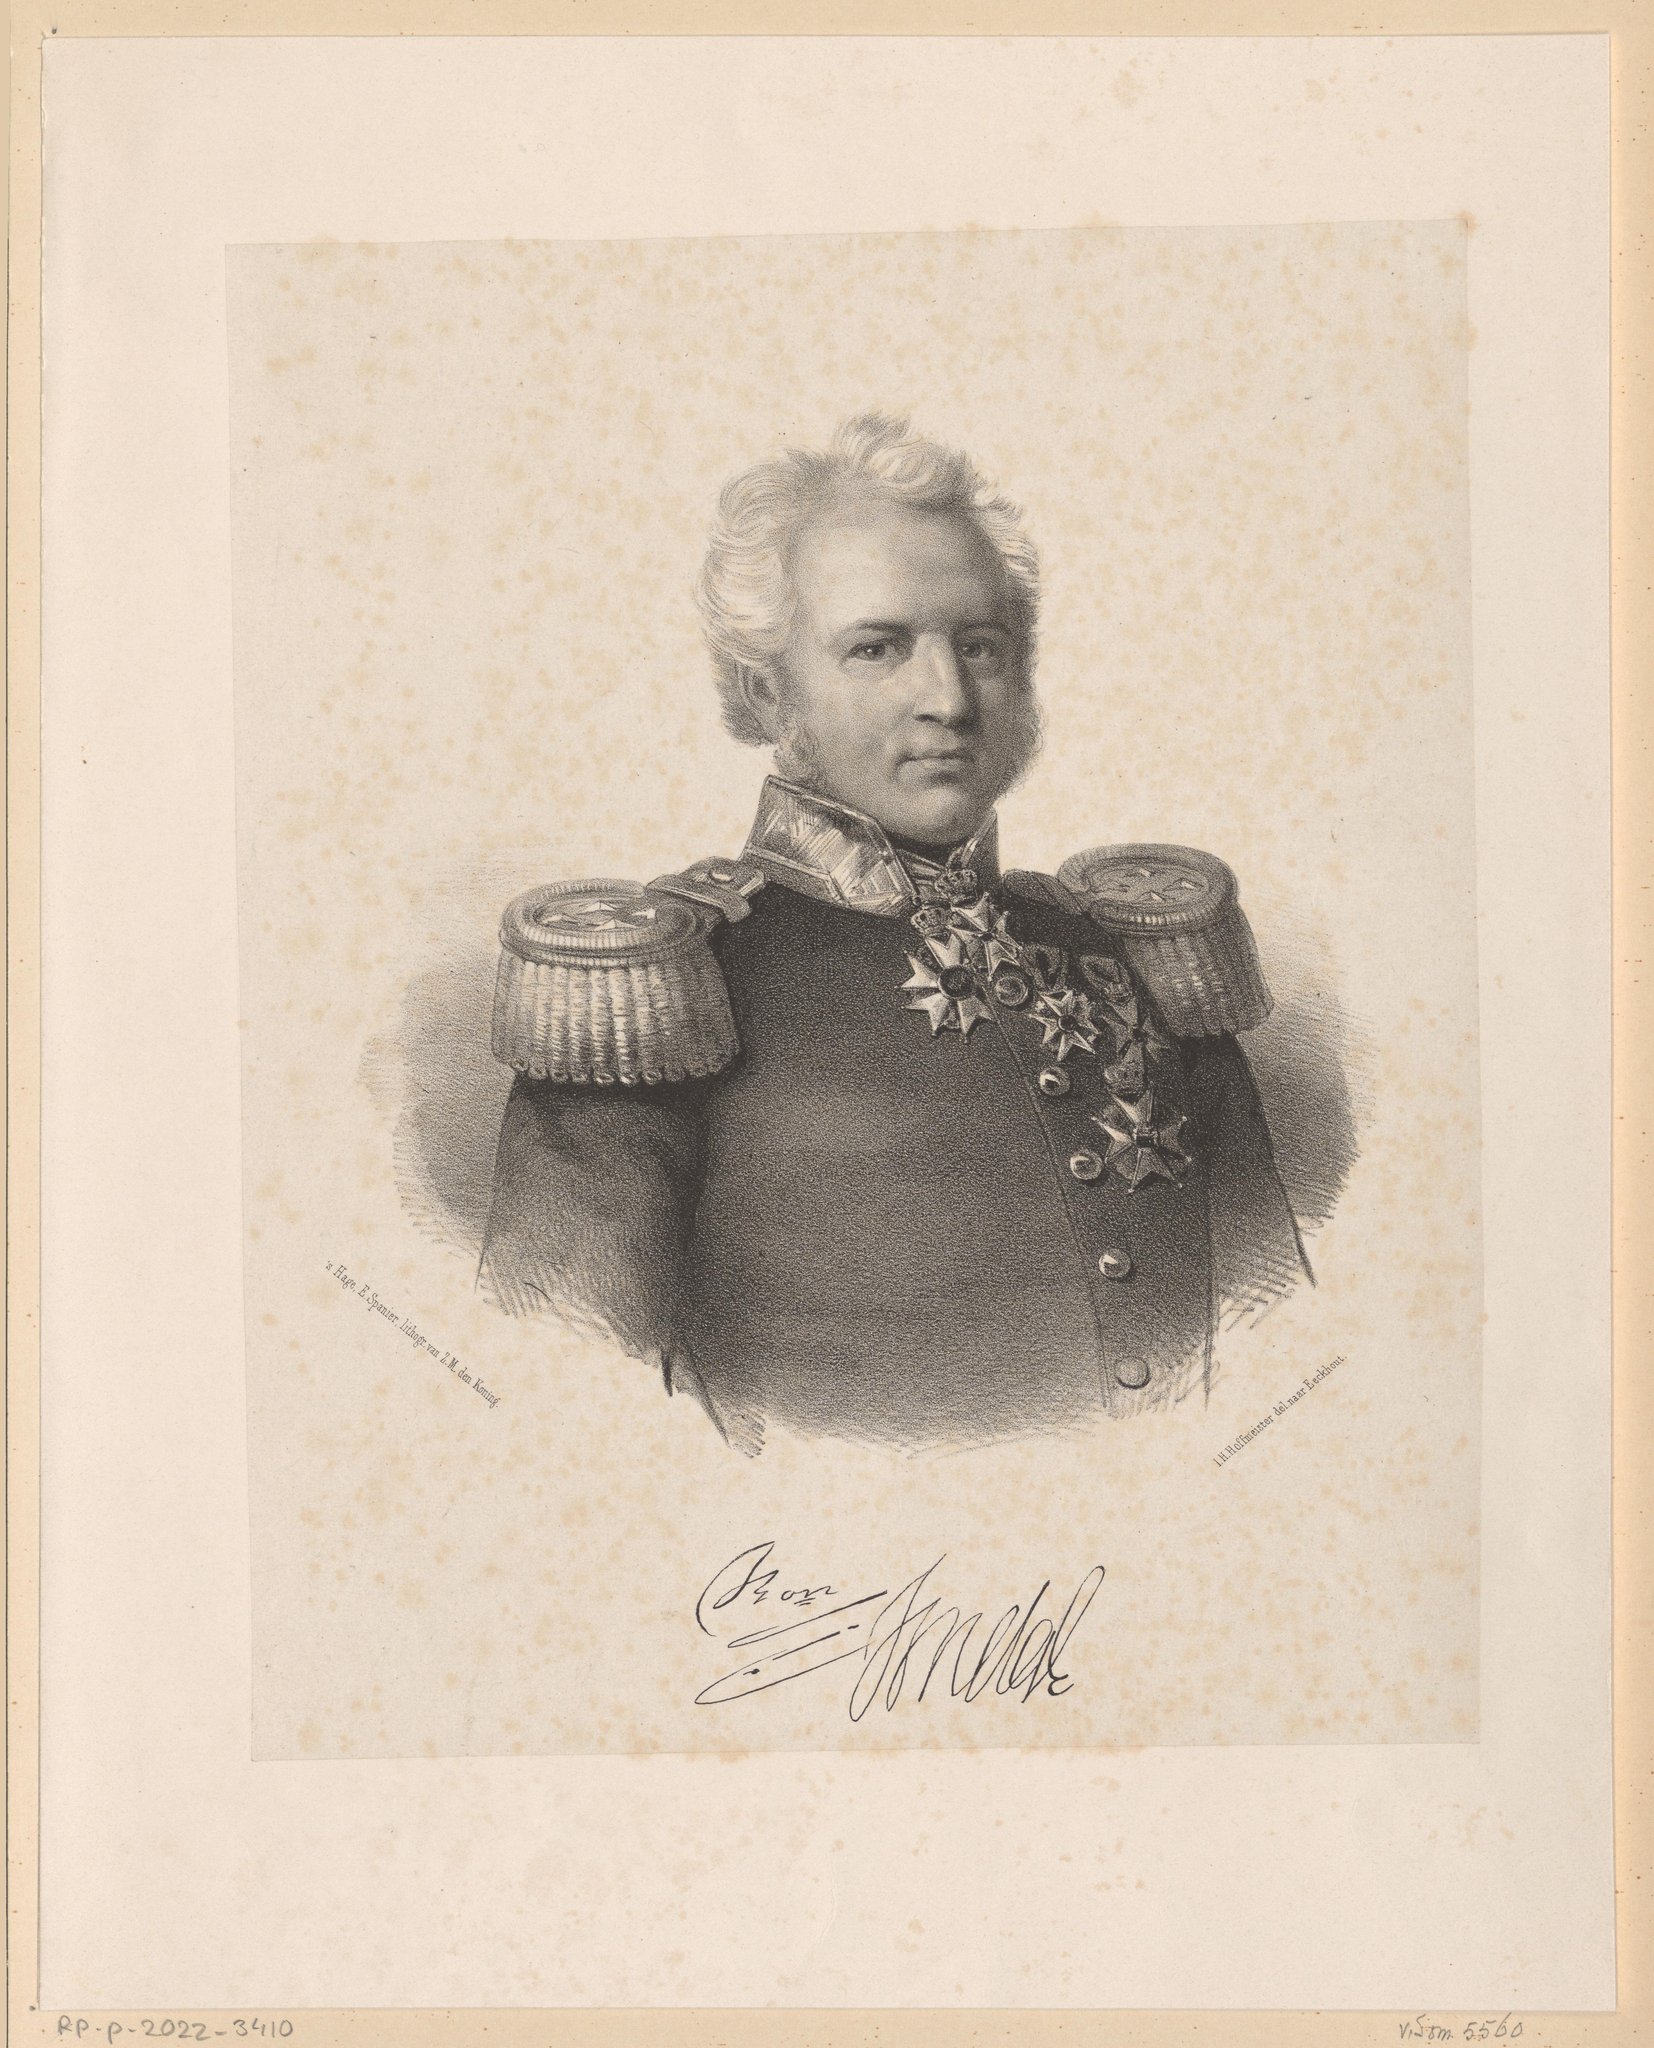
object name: print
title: Portret van Ralph Dundas Tindal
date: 1851-1883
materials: paper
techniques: lithograph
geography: the hague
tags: zeist, historical persons, medals and other marks of military honour